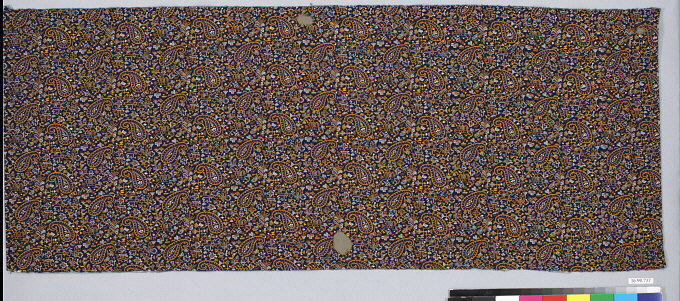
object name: piece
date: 1867-1900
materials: cotton